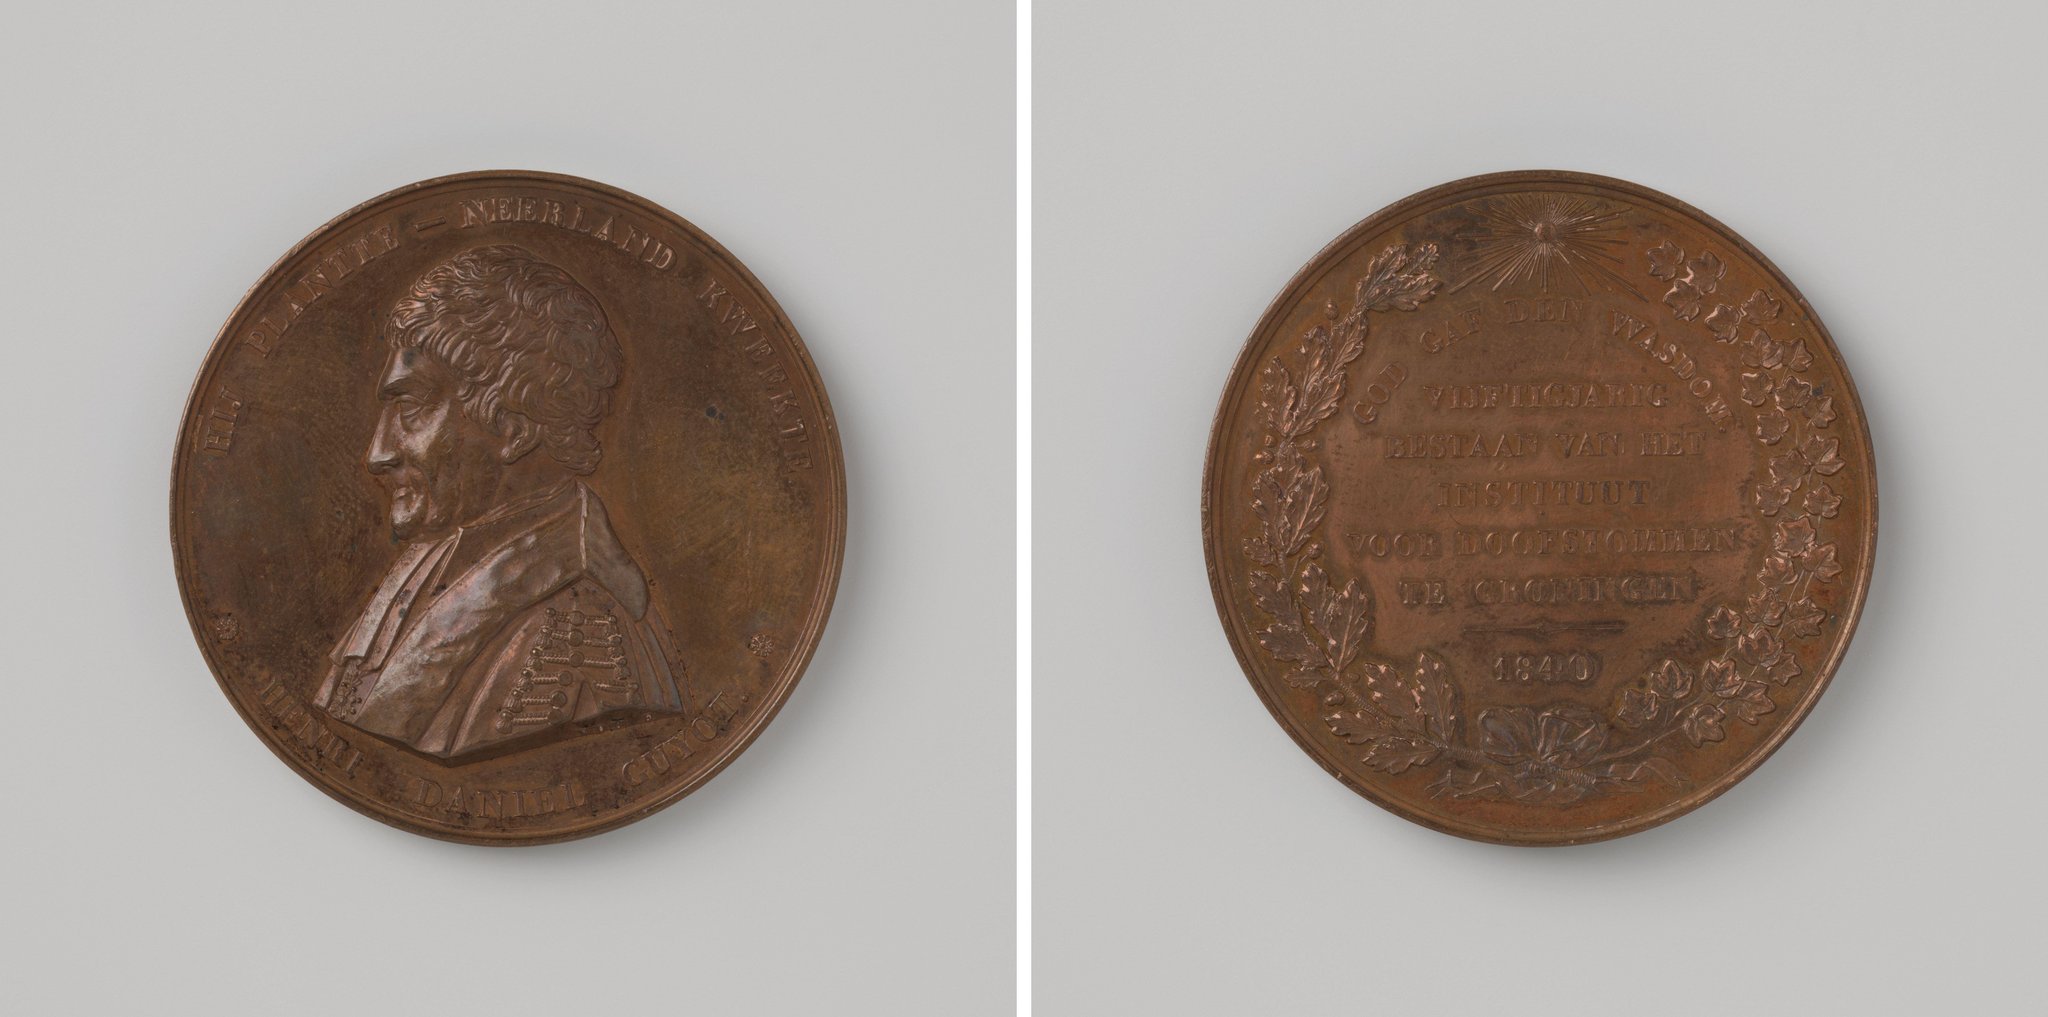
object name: history medal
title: Vijftigjarig bestaan van het Instituut voor Doofstommen te Groningen, opgericht door Henri Daniel Guyot, 1840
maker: david van der kellen (1804-1879)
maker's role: die cutter, draughtsman, print maker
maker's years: 1804-1879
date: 1840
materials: bronze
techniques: striking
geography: utrecht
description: Bronzen penning, op de voorzijde het borstbeeld van Guyot naar links met omschrift, op keerzijde zeven regels tekst onder een kleine stralende zon tussen een samengestrikte eiken- en klimoptak.